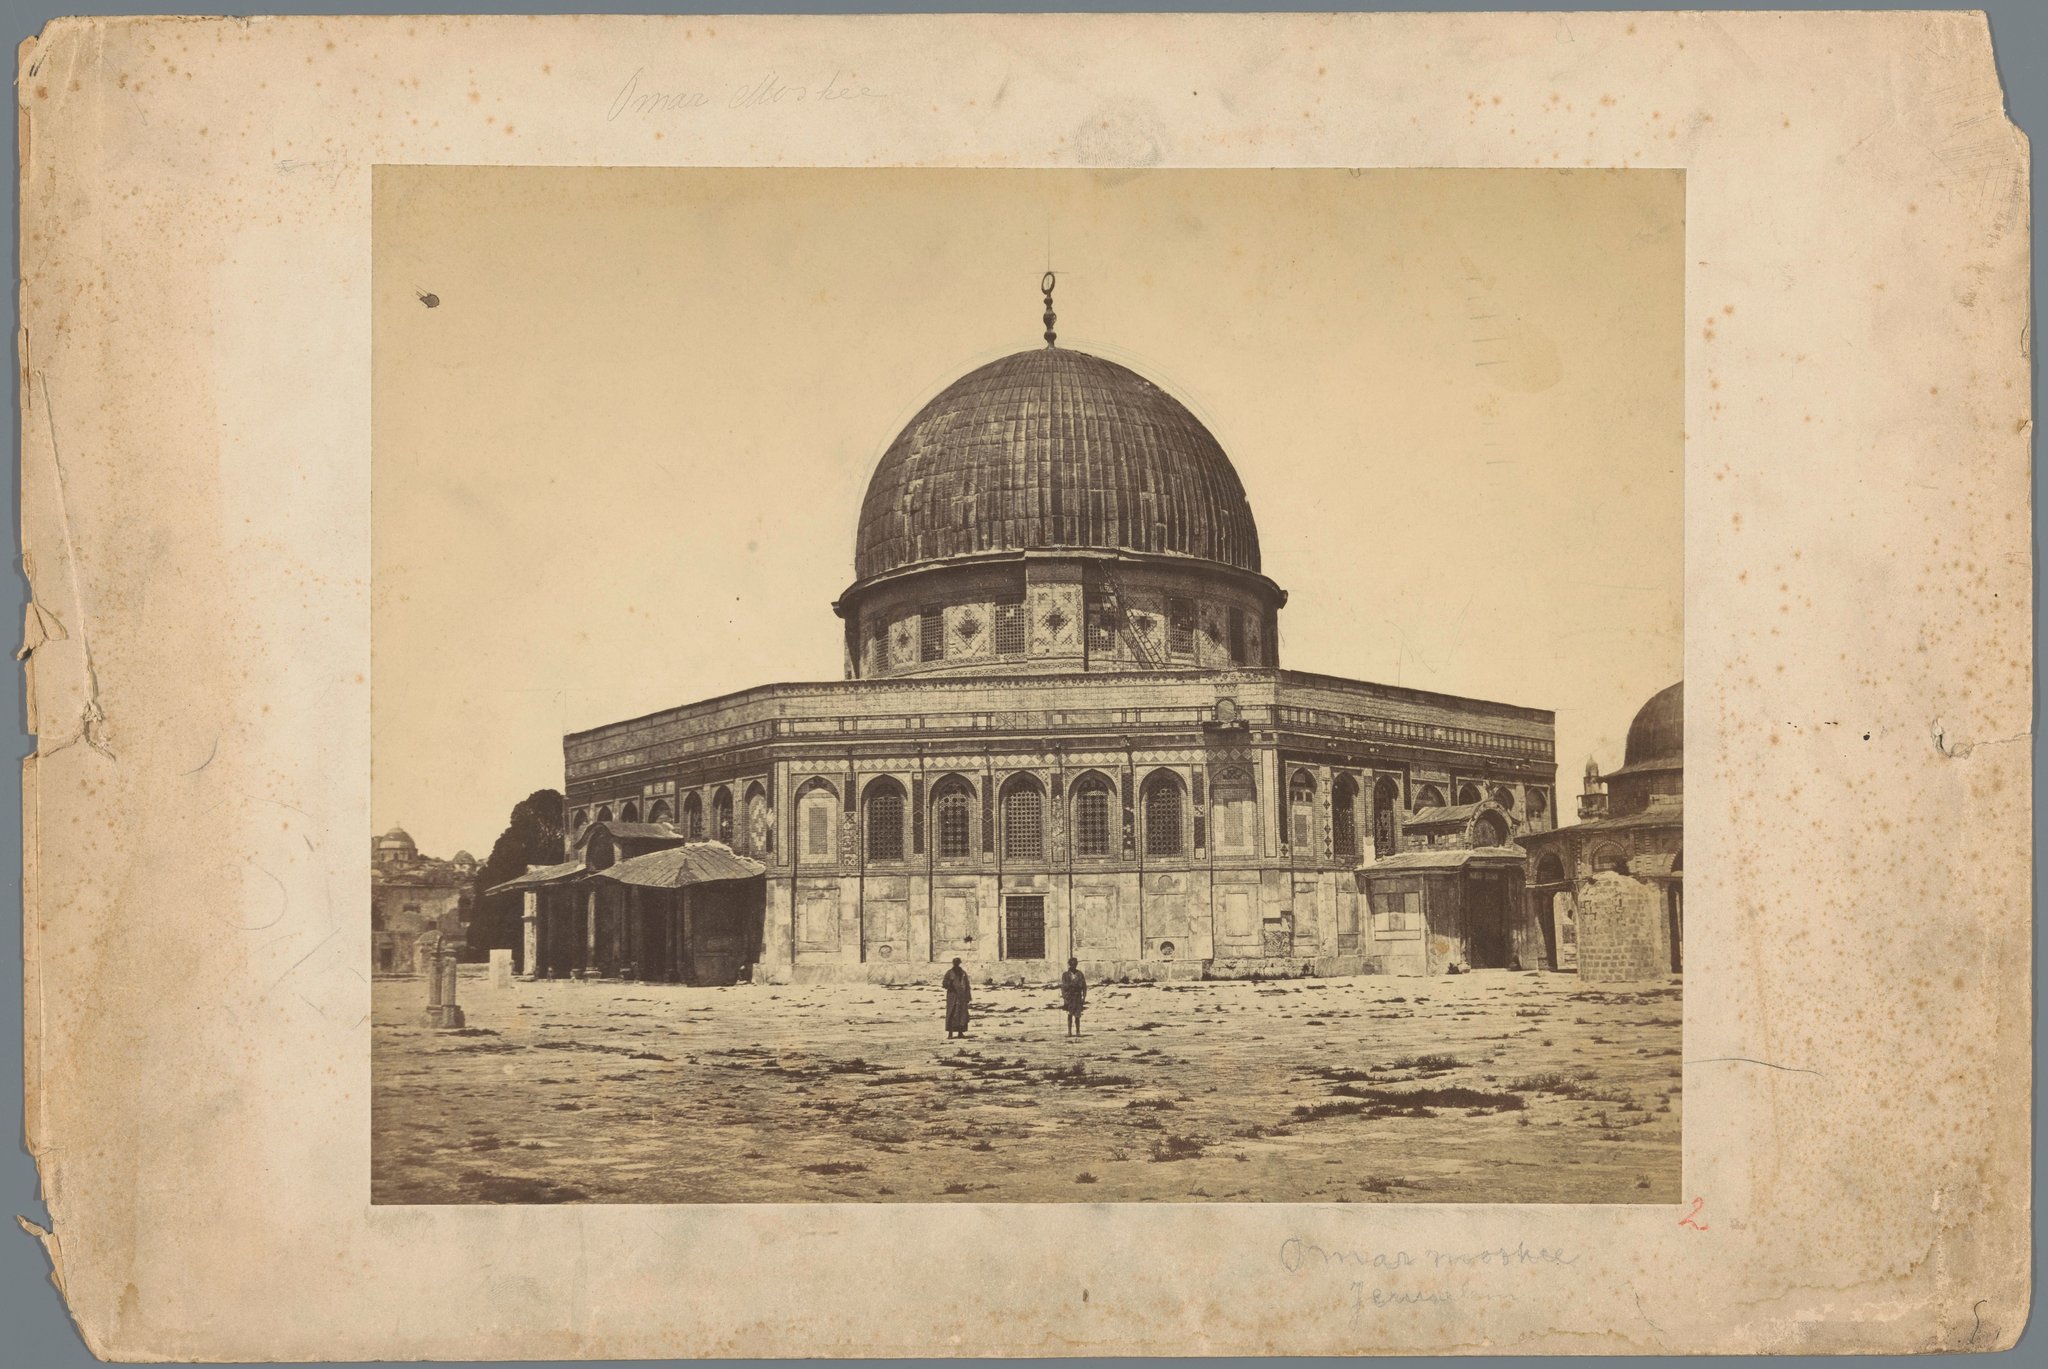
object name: photograph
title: Omar moskee Jerusalem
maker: Anonymous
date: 1875-1900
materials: cardboard, photographic support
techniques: albumen print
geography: jerusalem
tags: temple, shrine ~ non-christian religions, dome ~ architecture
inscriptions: annotation, collector's mark: Lugt 3937